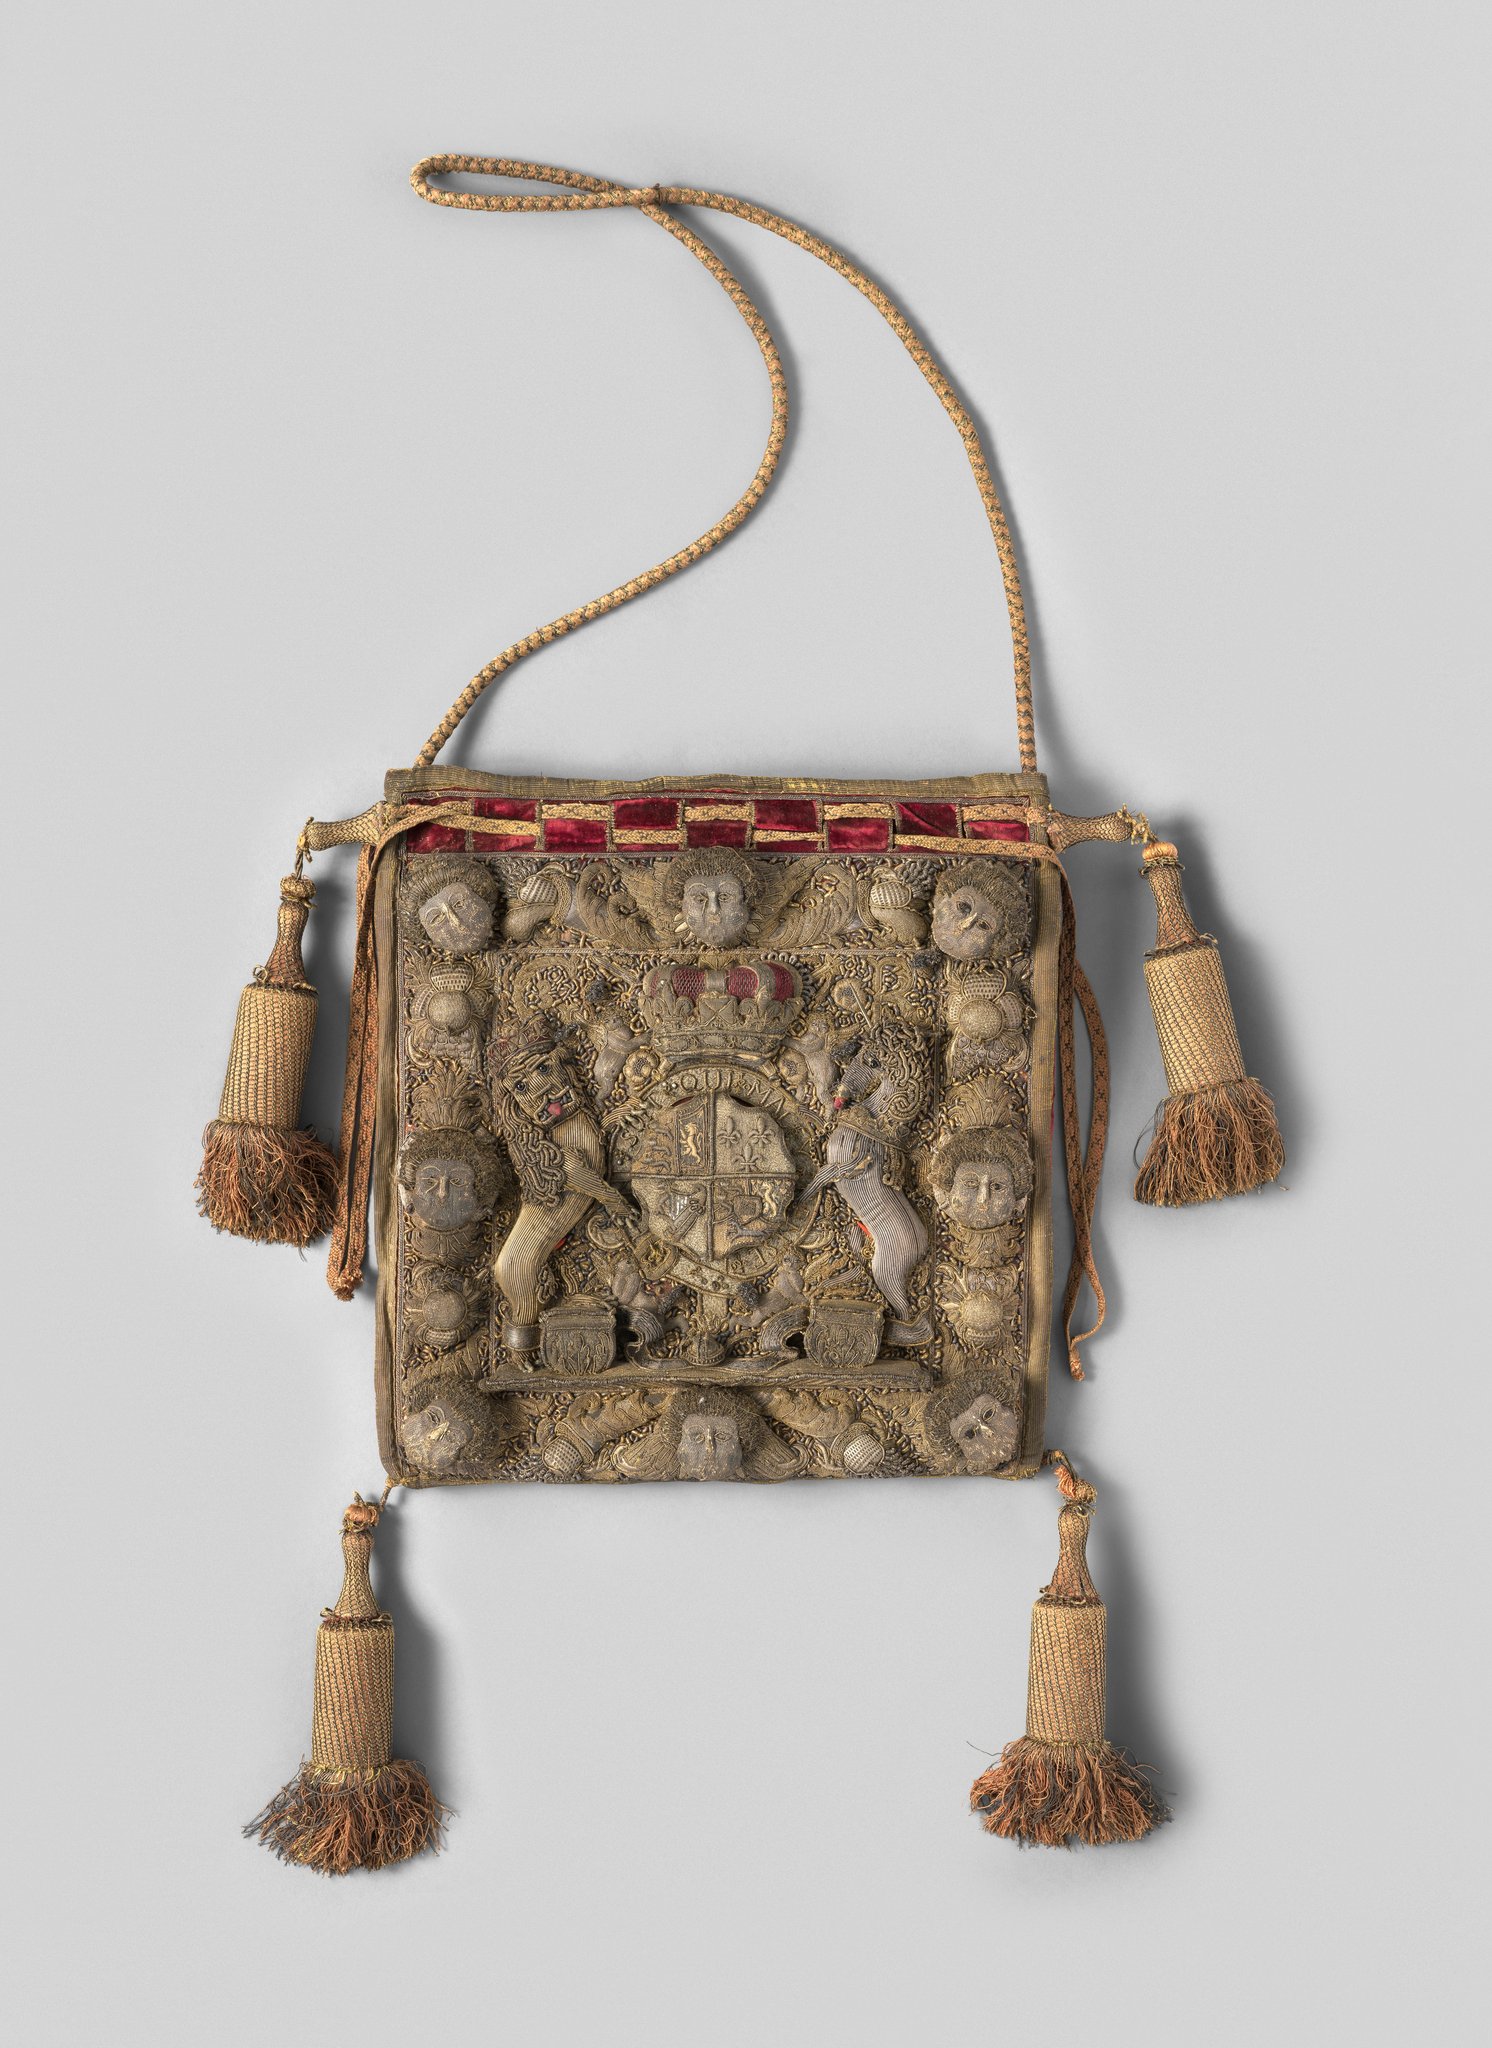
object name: burse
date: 1751-1800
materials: metal thread, silk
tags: coat of arms